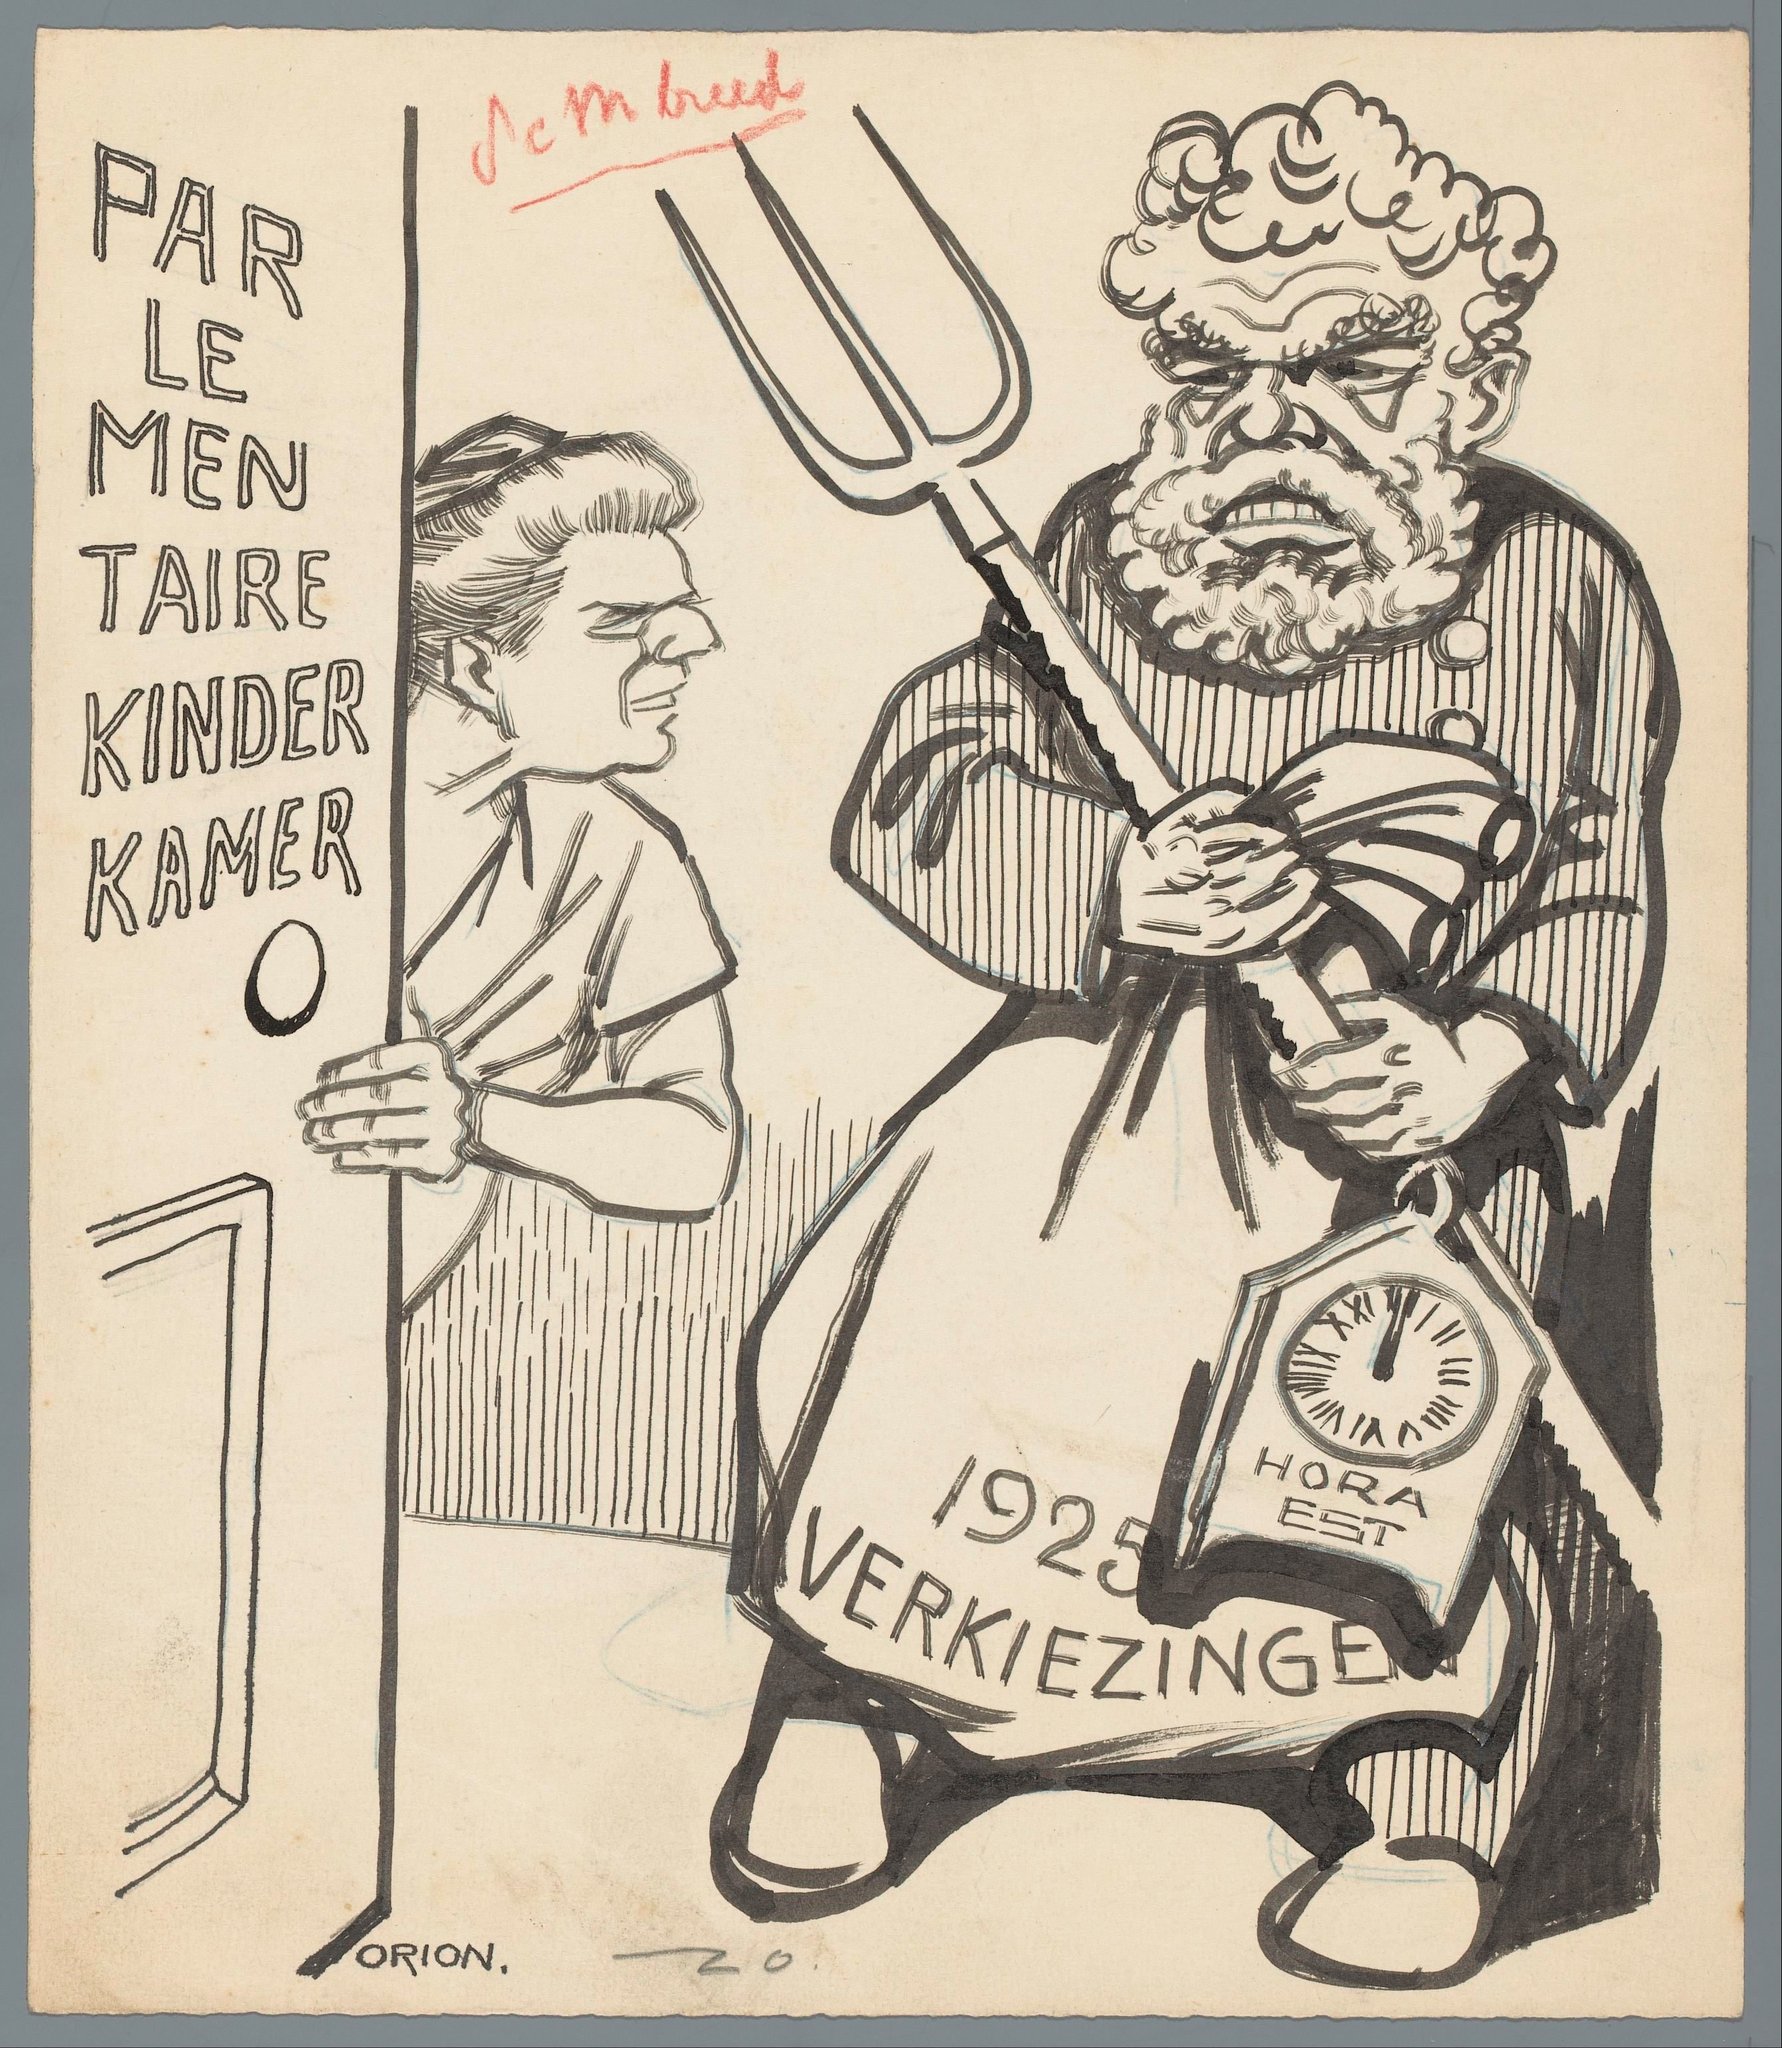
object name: cartoon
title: Verkiezingen van 1925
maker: patricq kroon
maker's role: draughtsman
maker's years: 1862-1941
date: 1925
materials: ink, paper, pencil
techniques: pen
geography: netherlands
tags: voting, election, political caricatures and satires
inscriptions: inscription: ‘Als Hij komt / De Kamermaagd: Och ja, Opa! ze beginnen ...’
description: Boze man met drietand, zak en klok met 'Hora Est' bij de 'Parlementaire Kinderkamer', naar aanleiding van de verkiezingen van 1925. Ontwerp voor een politieke spotprent.